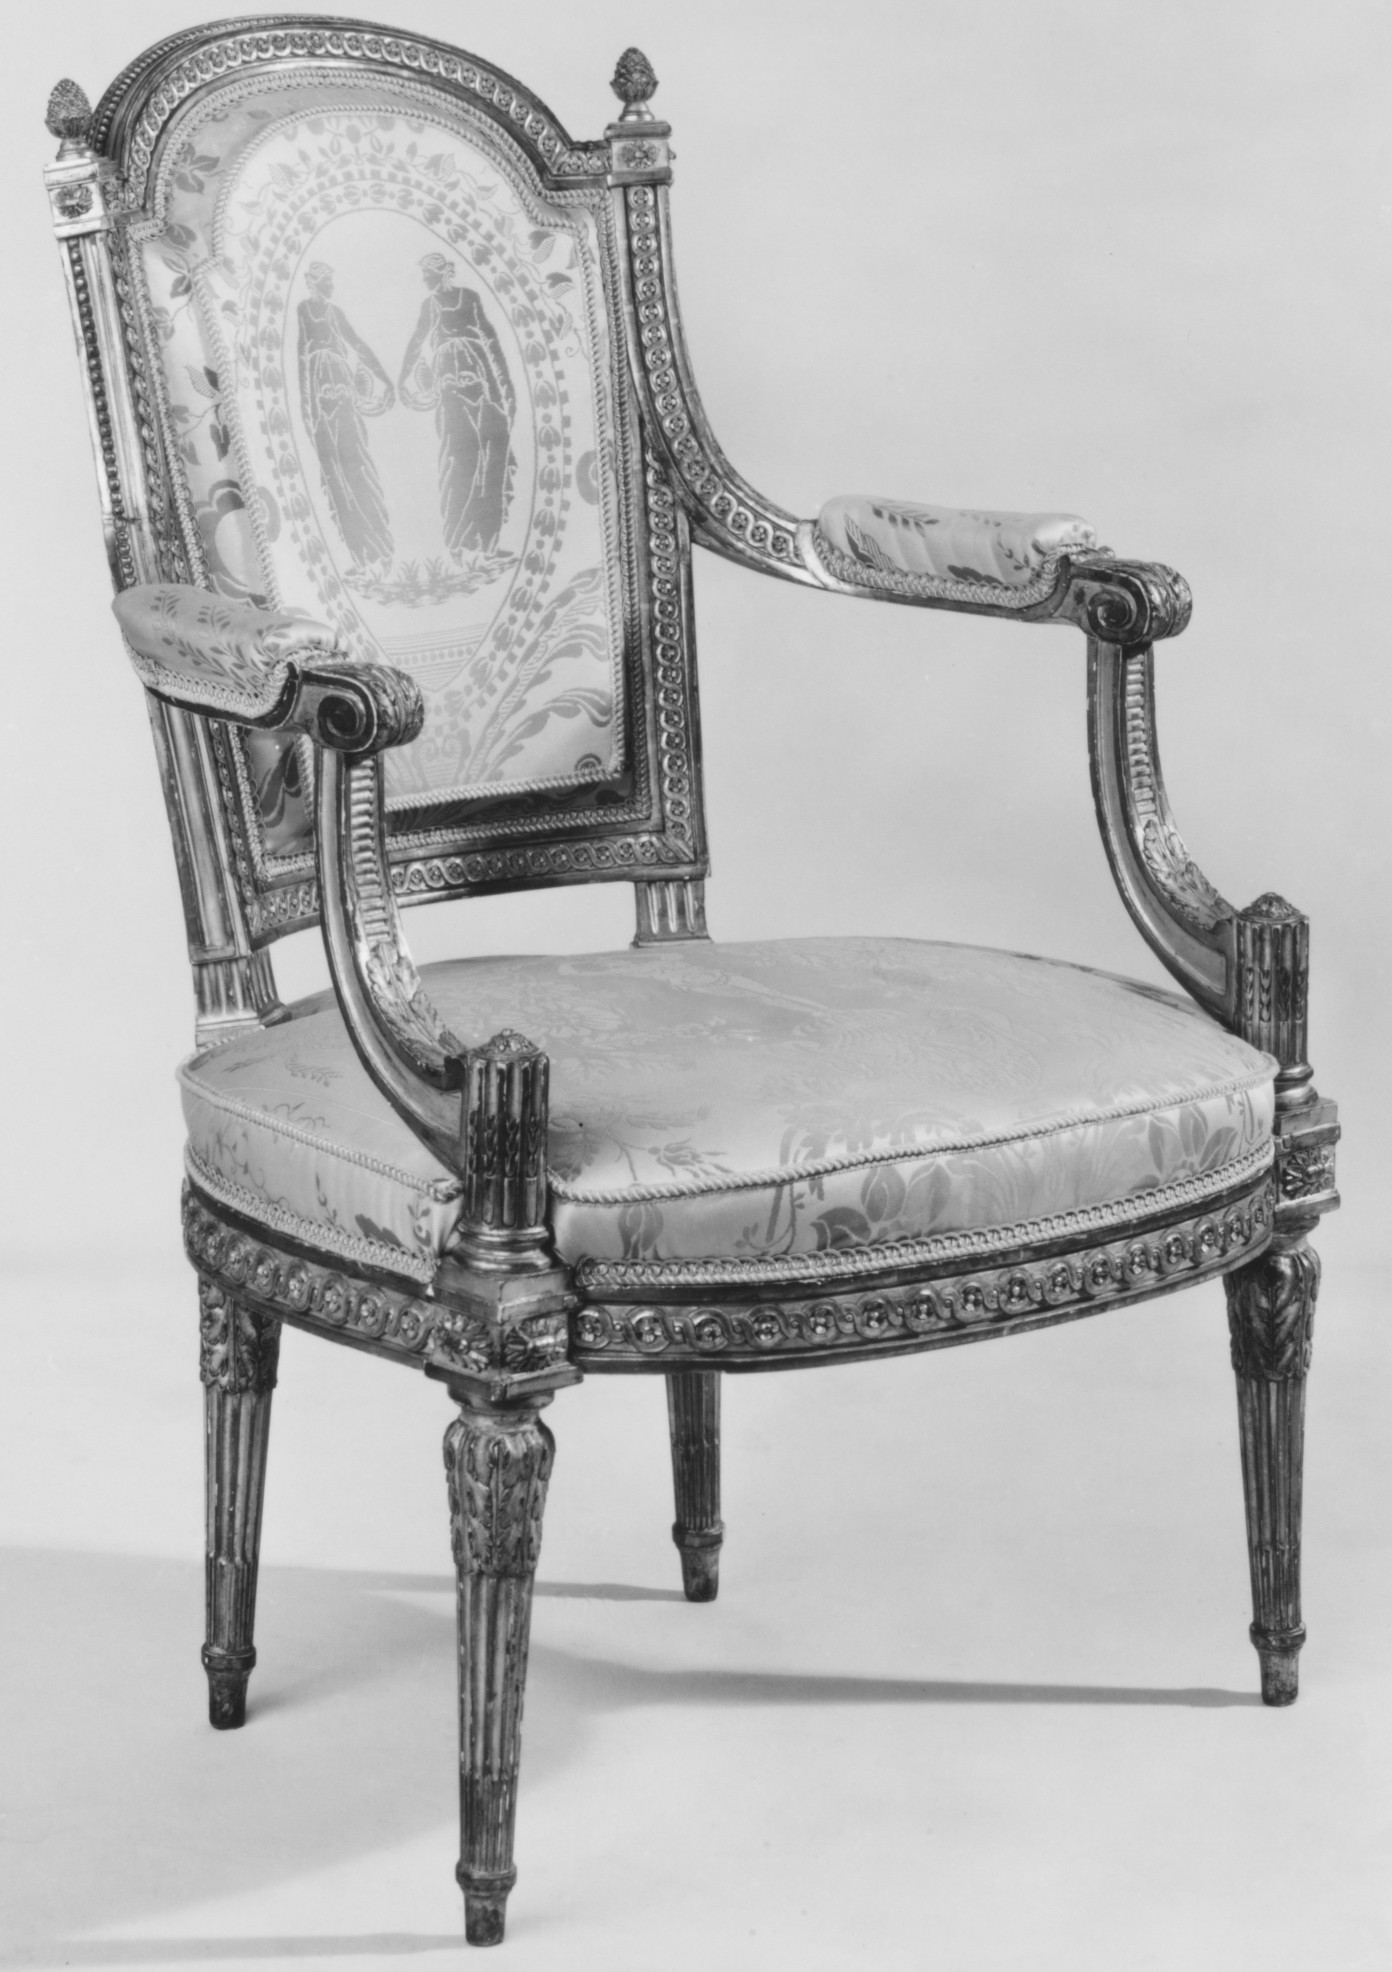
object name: armchair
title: Armchair (fauteuil en cabriolet) (one of a pair) (part of a set)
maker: jean-baptiste-bernard demay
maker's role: maker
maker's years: 1759-1849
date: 1785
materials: wood, silk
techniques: carving, gilding, lampas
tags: women